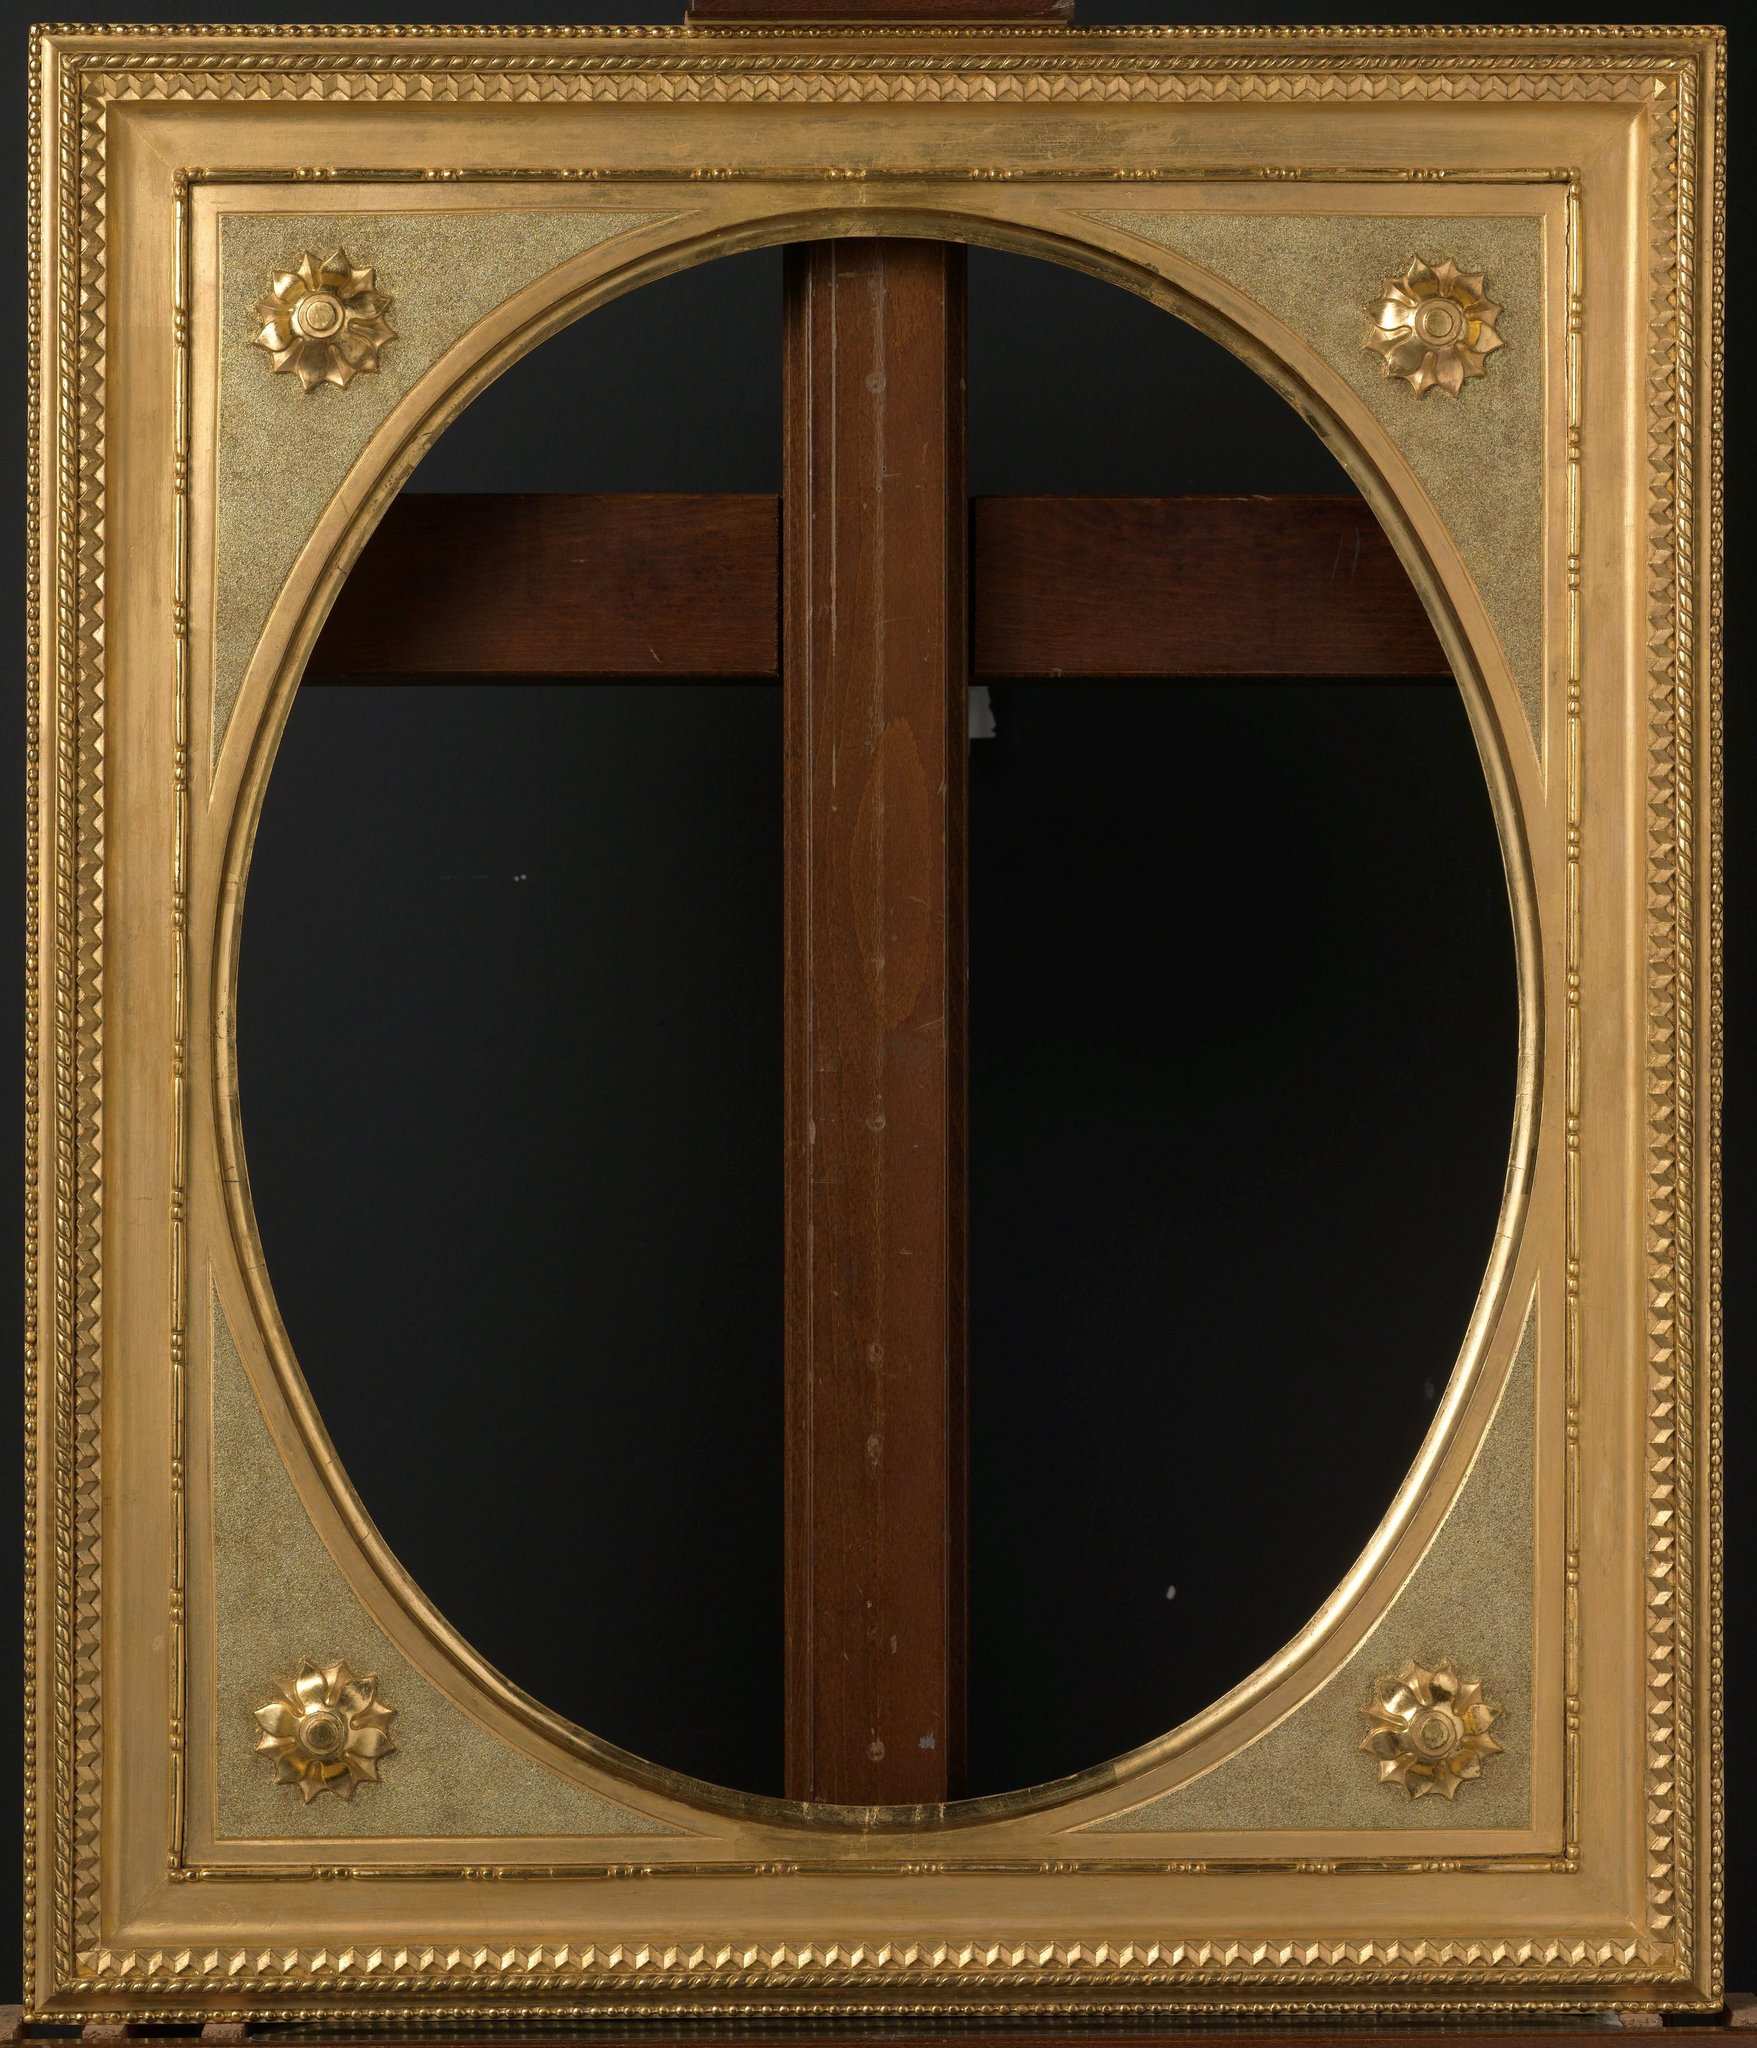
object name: frame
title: Schilderijlijst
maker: hendrik ebbens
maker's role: lijstenmaker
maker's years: 1726-1807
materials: wood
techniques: gilding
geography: the hague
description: Rechthoekig verguld kader waarin een ovaal is uitgespaard. De buitenrand versierd met een parelrand, daarbinnen een rand met touwmotief, daarbinnen een zigzagrand. In de hoeken een rozet. Aan de bovenregel en onderregel een uitstekende rand met de namen van de vervaardiger en de voorgestelde.